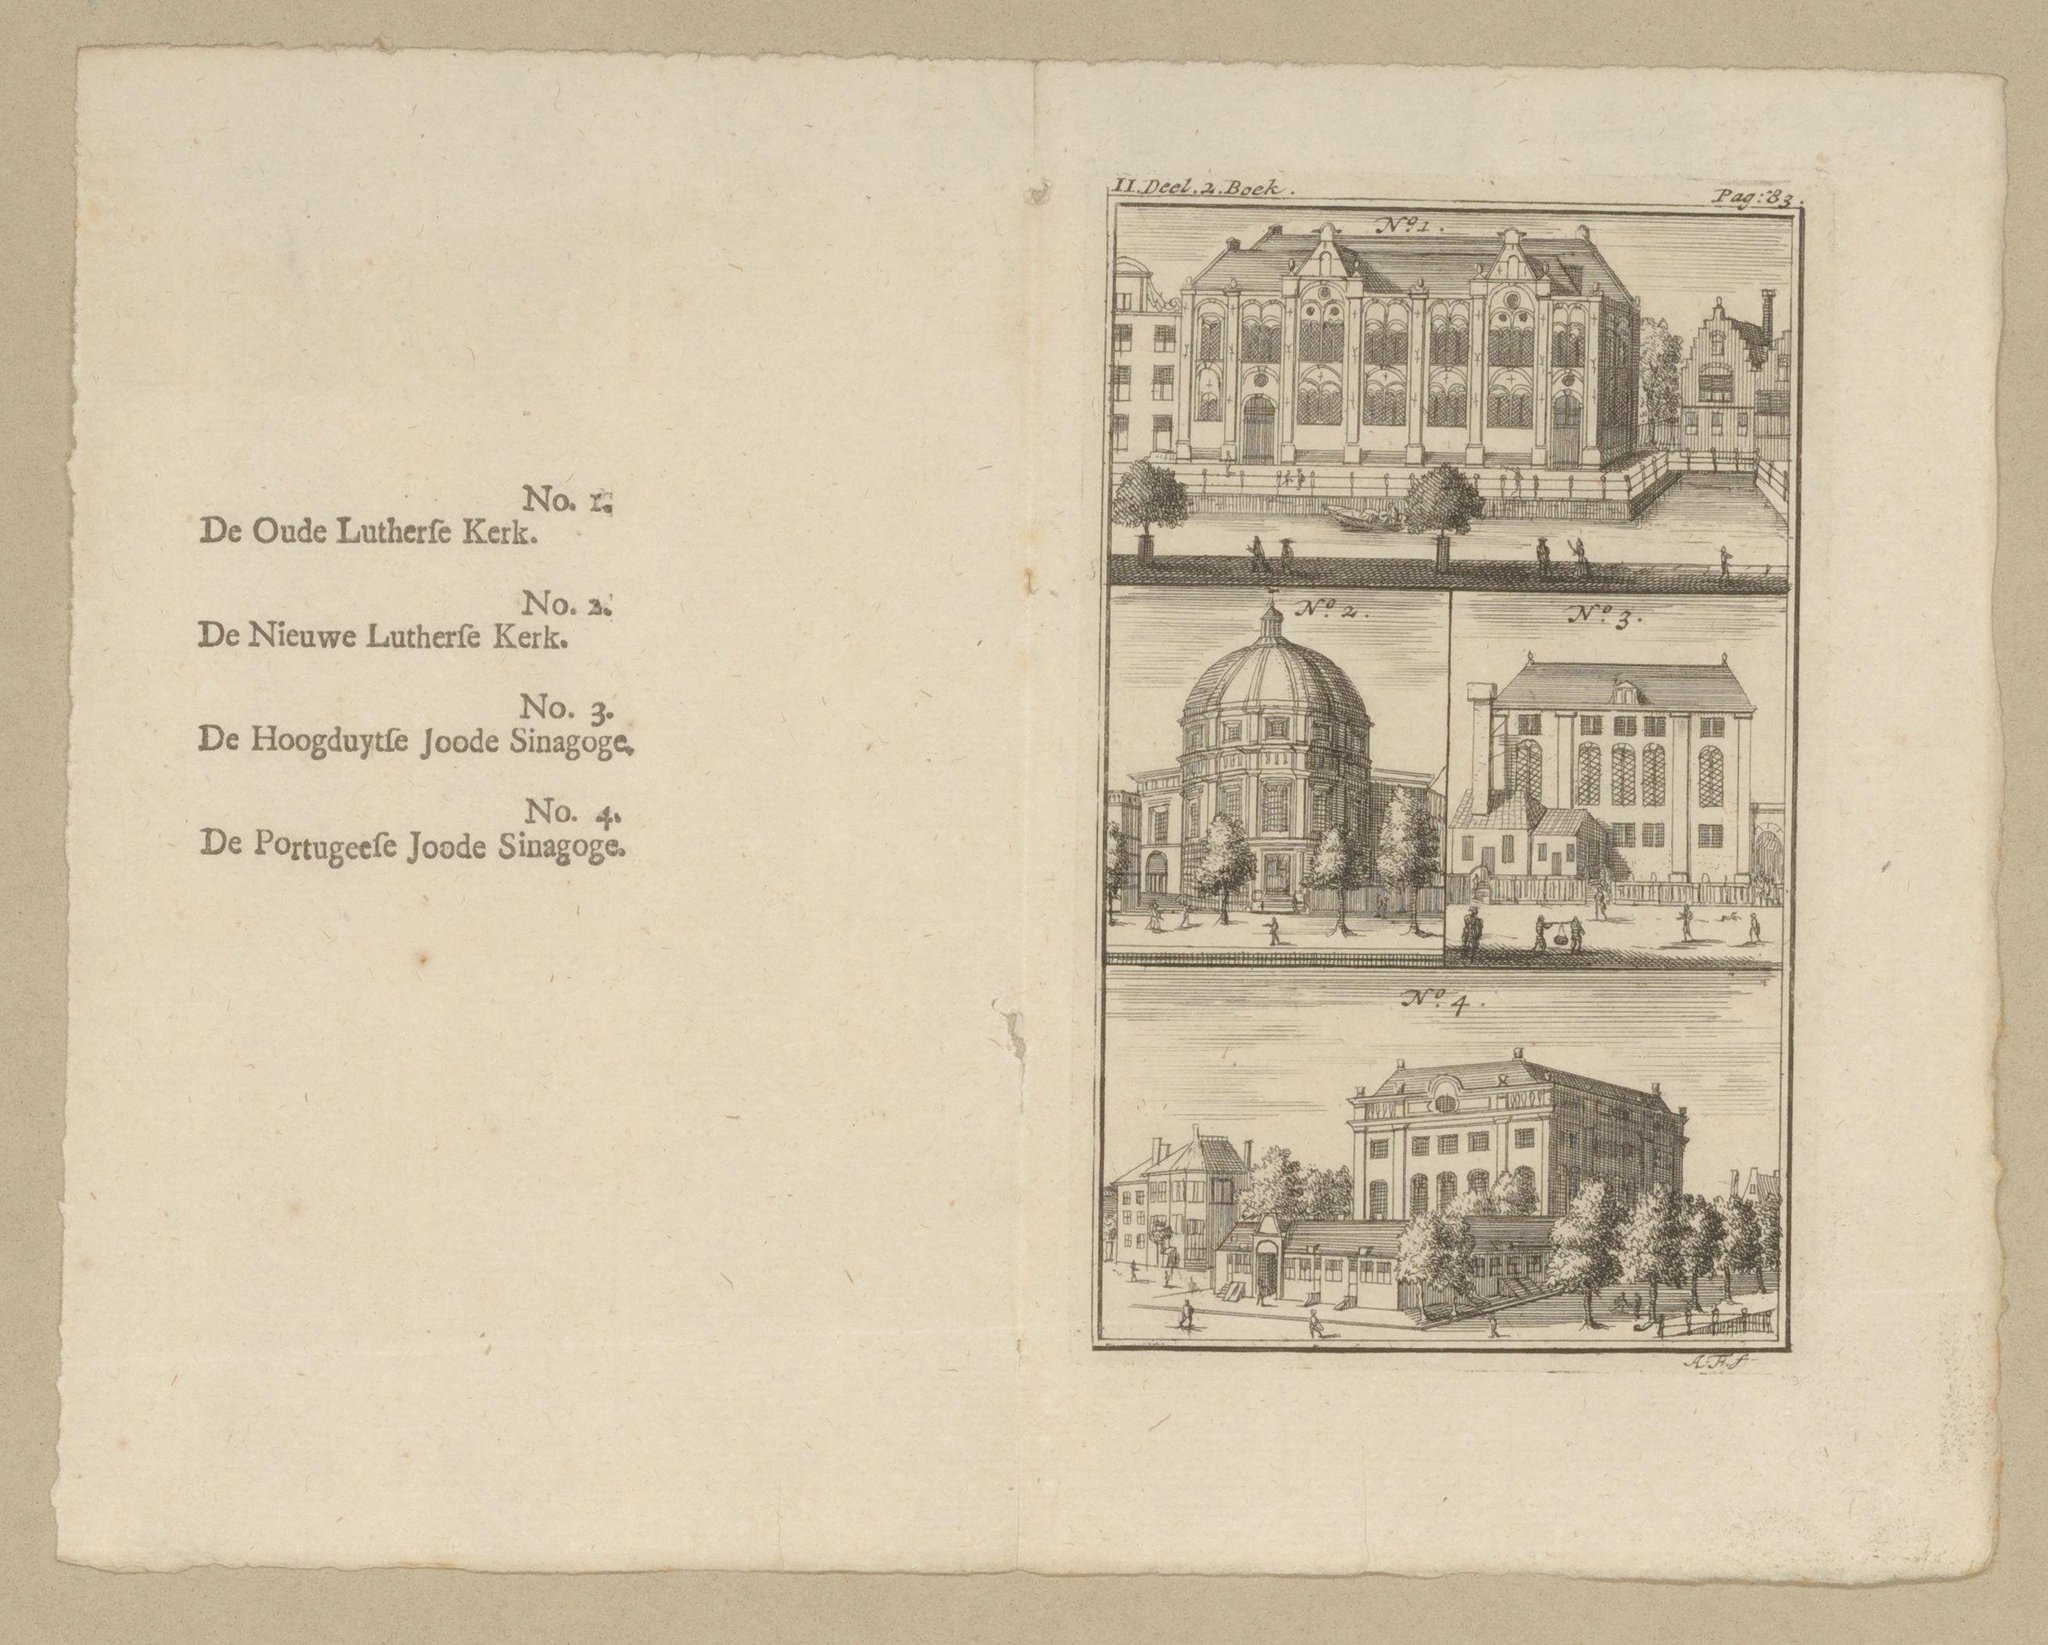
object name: print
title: Vier verschillende kerken en synagogen te Amsterdam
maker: anna folkema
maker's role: draughtsman, print maker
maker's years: 1695-1768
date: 1723-1730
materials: paper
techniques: etching, letterpress printing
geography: amsterdam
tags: the synagogue (as building and place of worship ~ jewish religion), church (exterior), city-view, and landscape with man-made constructions (+ city(-scape) with figures, staffage)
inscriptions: collector's mark: Lugt 1641b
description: Individuele voorstellingen van Oude Lutherse Kerk, Ronde Lutherse Kerk, Grote Synagoge en Portugees-Israëlietische Synagoge, genummerd van N° 1 tot en met N° 4. Bovenaan gemerkt: II. Deel. 2. Boek. / Pag: 83. Onderwerpsrubriek binnen de Atlas Amsterdam: Kerkwezen: Gebouwen diverse gemeenten: Verzamelbladen + Armeense Kerk.